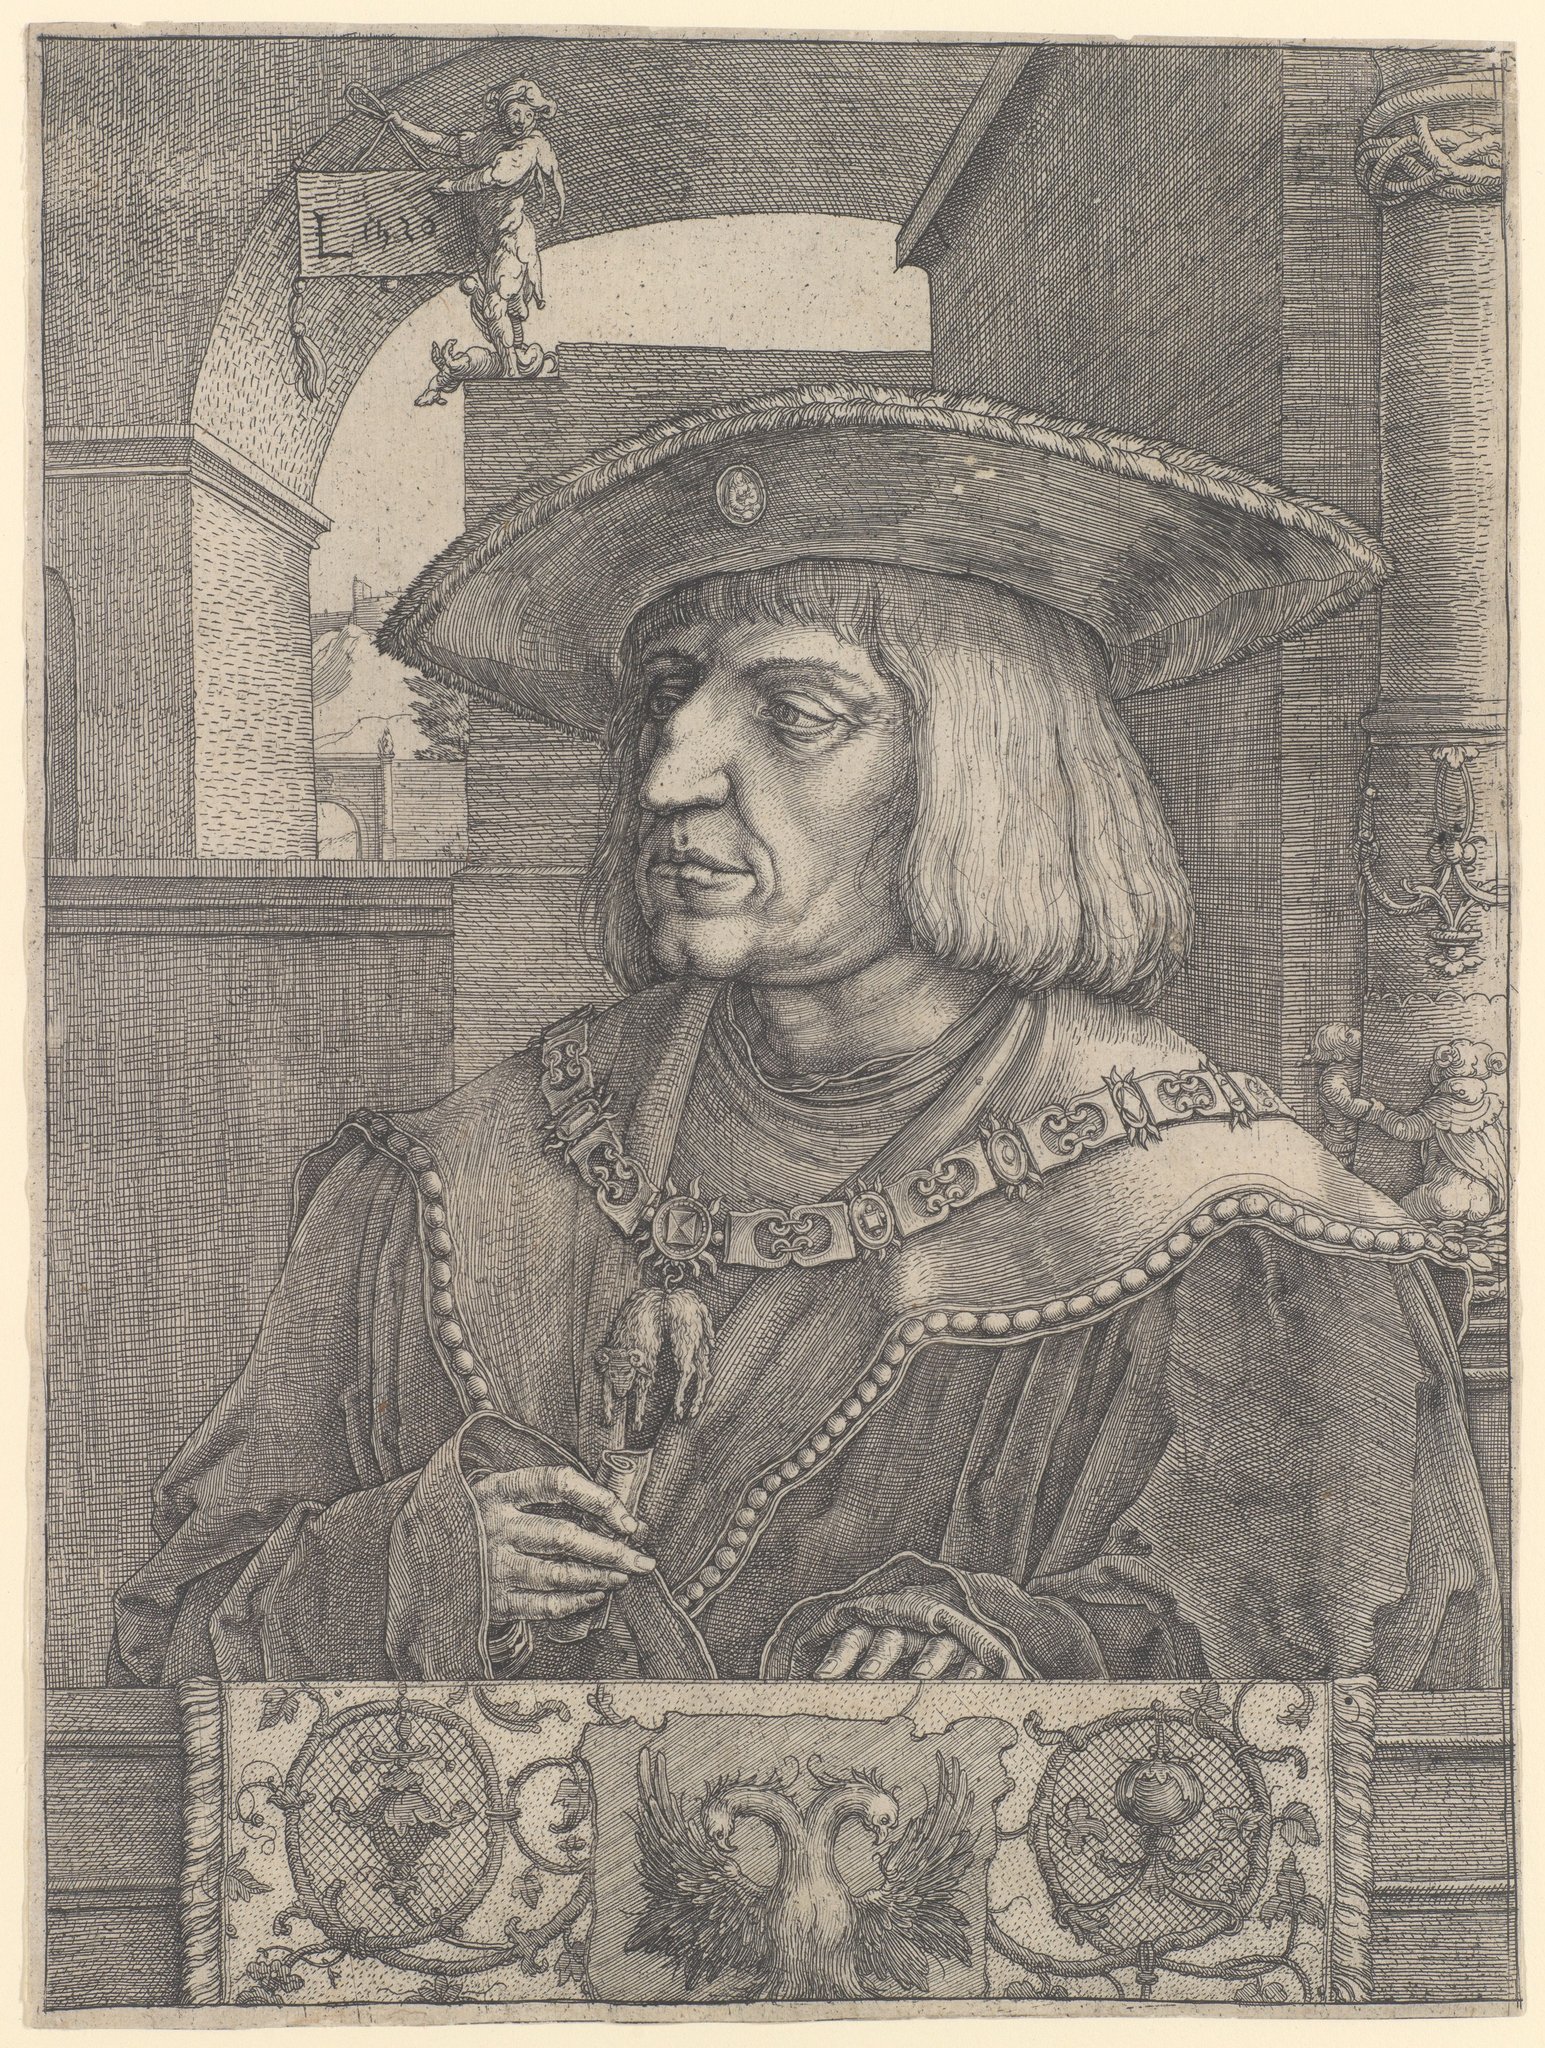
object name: print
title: Maximilian I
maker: lucas van leyden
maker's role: artist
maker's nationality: netherlandish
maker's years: 1494-1533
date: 1520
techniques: engraving, etching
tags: men,portraits